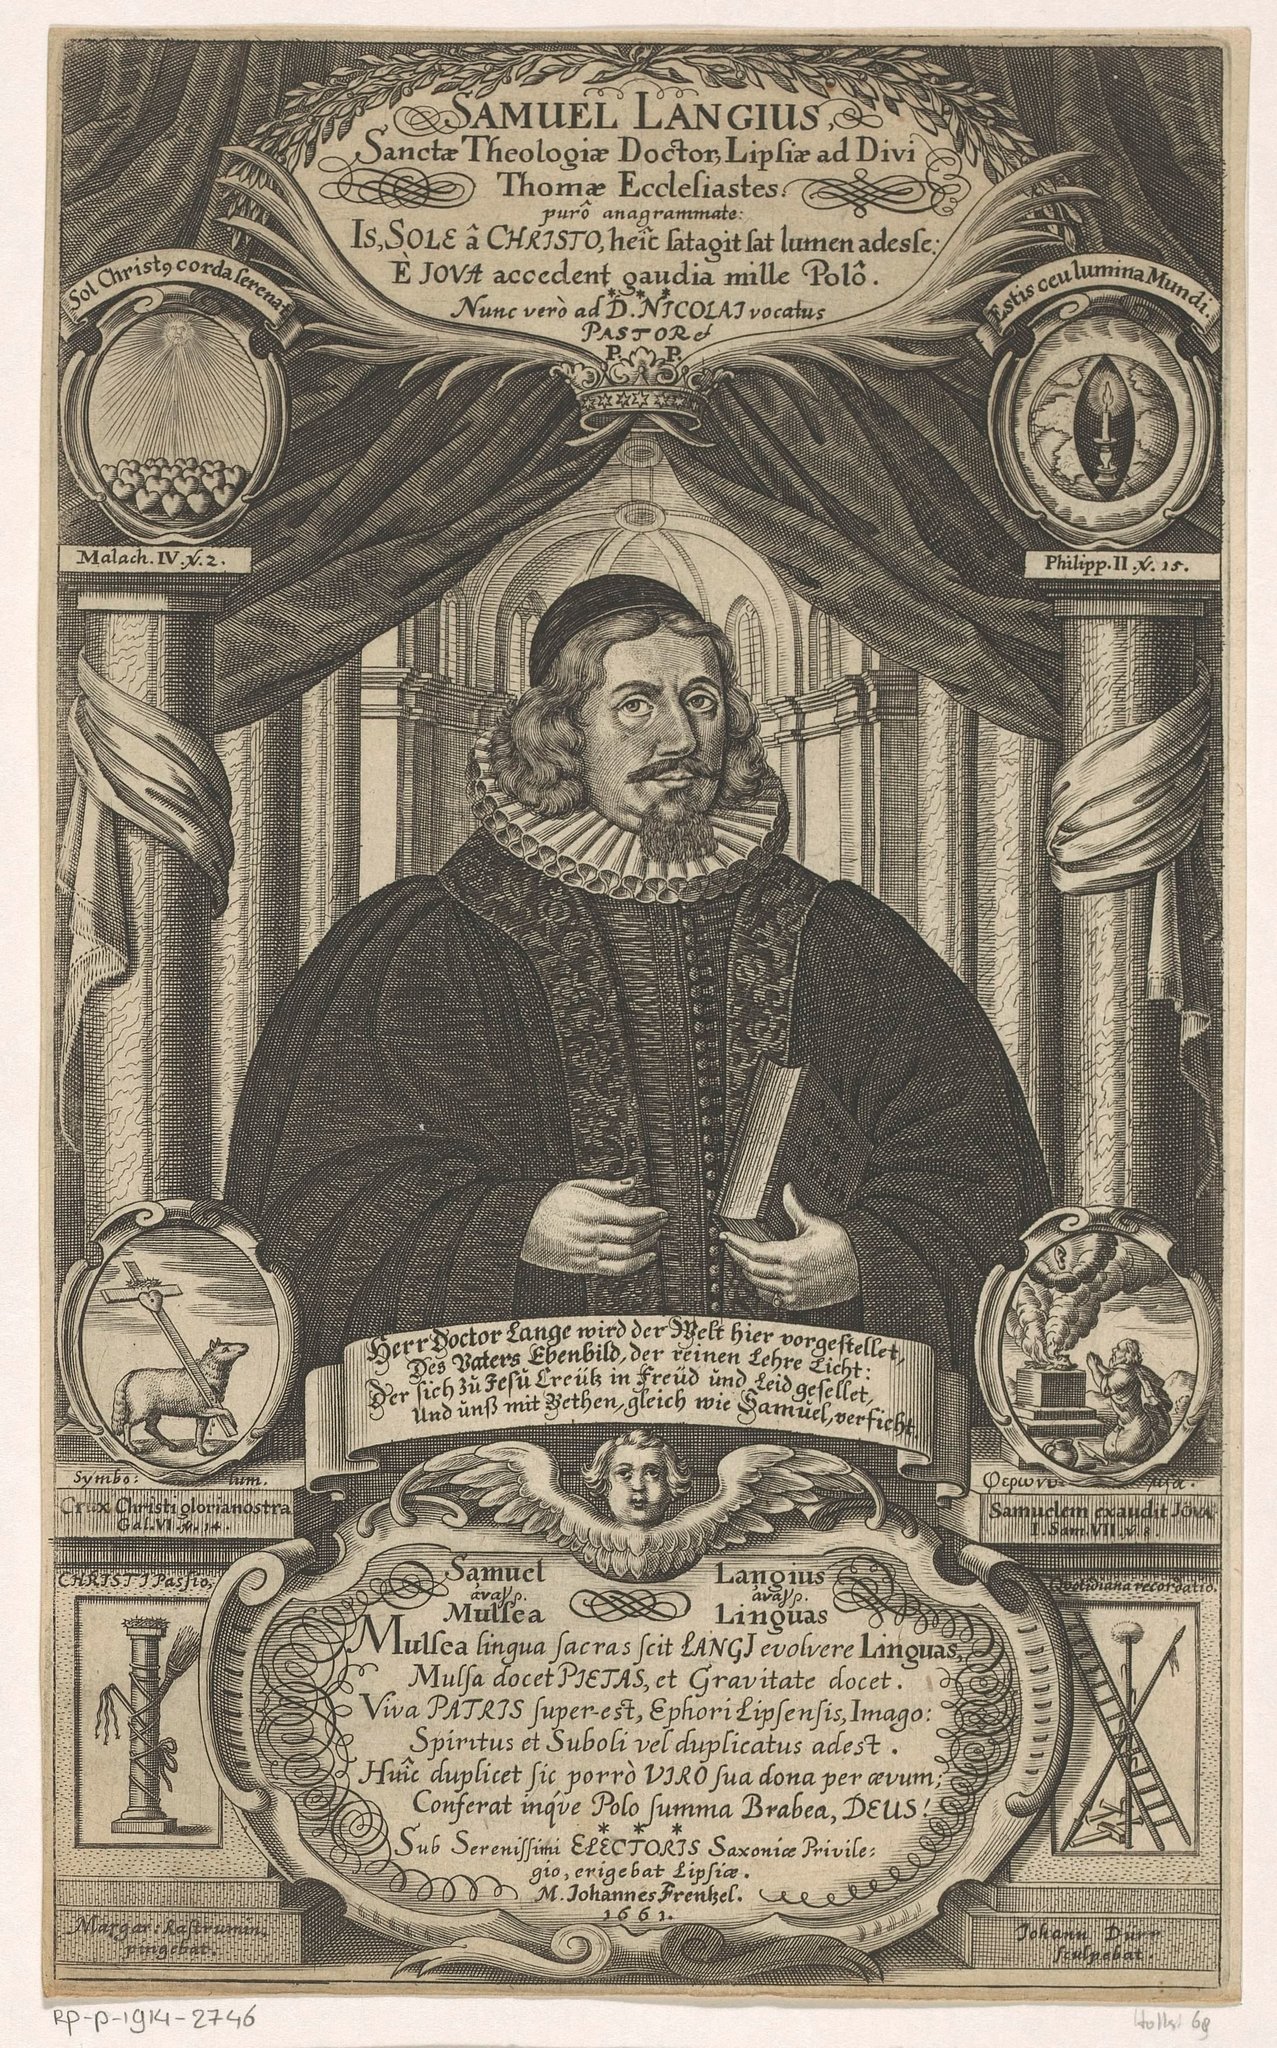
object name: print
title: Portret van Samuel Lange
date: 1661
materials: paper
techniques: engraving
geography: saxony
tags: earth, world as celestial body, crown (symbol of sovereignty), cherubs, i.e. children's heads with wings, lamb bearing cross or banner, 'agnus dei' ~ symbol of christ, heart symbolism, single instruments of the passion, samuel communicating with god, historical persons, book, candle, ornament ~ cartouche, ornament derived from architectural details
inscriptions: collector's mark: Lugt 2228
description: Portret in architecturale omlijsting, met onder in cartouche een lofdicht in het Latijn. Omlijsting versierd met christelijke symboliek.